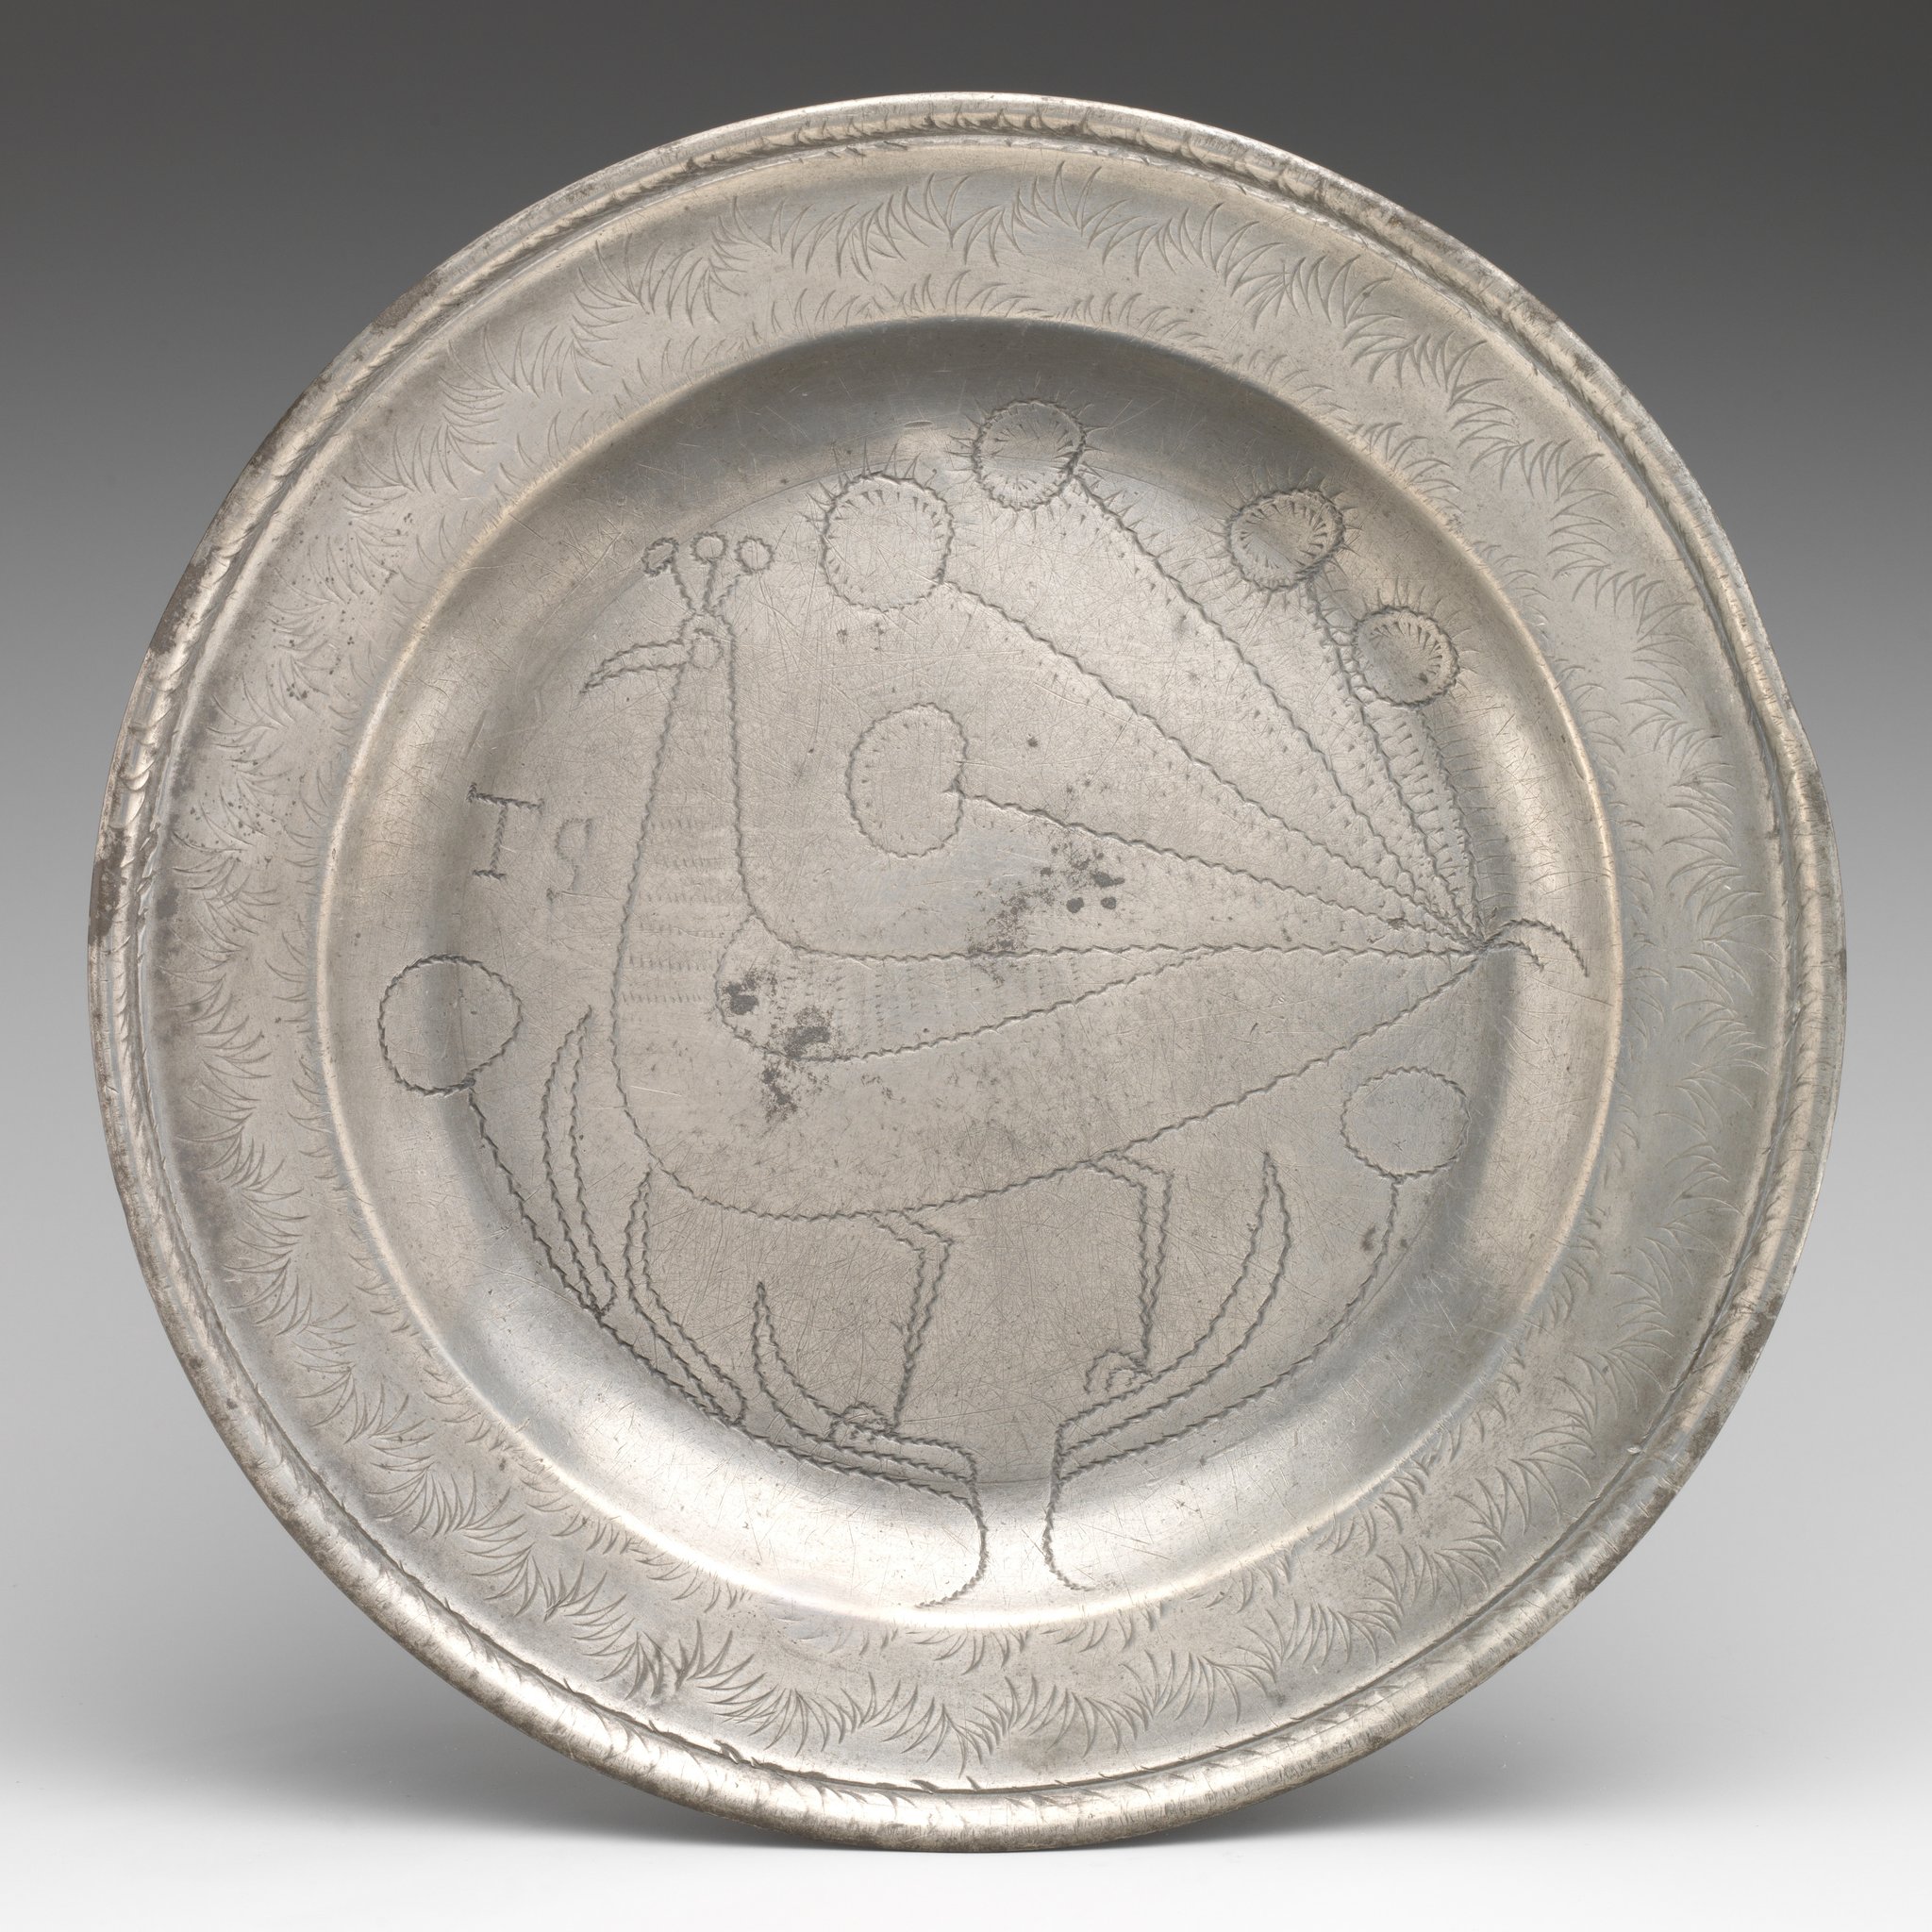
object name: plate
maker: james hitchman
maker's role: maker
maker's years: 1701-1733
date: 1701-1725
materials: pewter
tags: peacocks